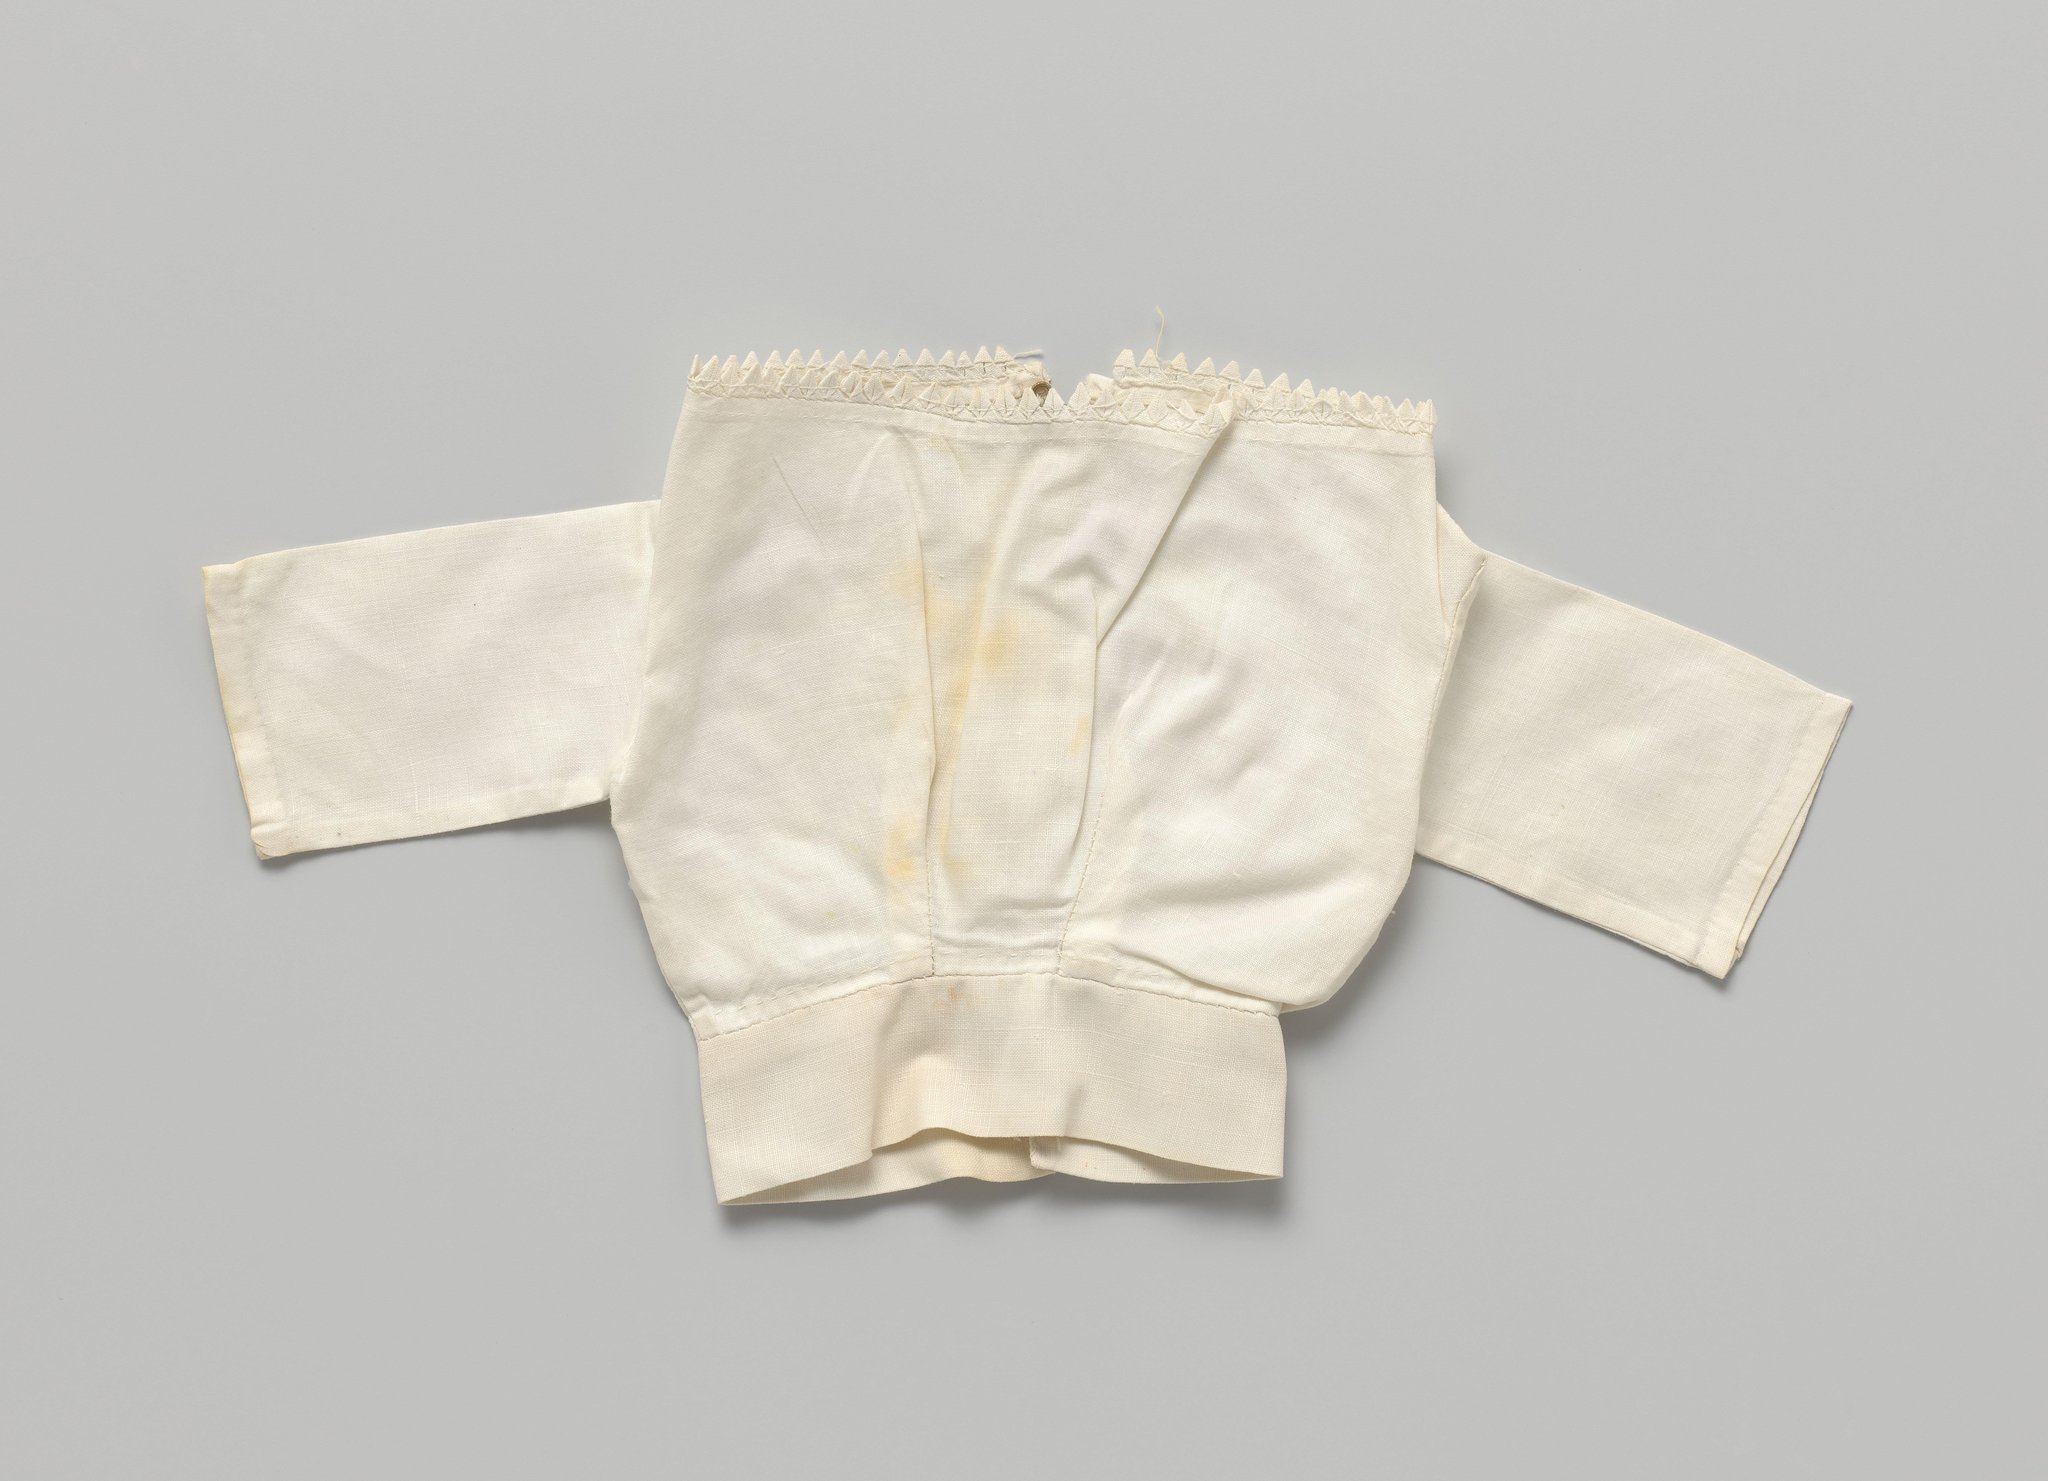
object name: doll's clothing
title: Wit lijfje met opstaande kraag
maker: Anonymous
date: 1850-1920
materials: metal, textile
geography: netherlands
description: Het lijfje sluit aan de achterzijde met twee haakjes van metaal.